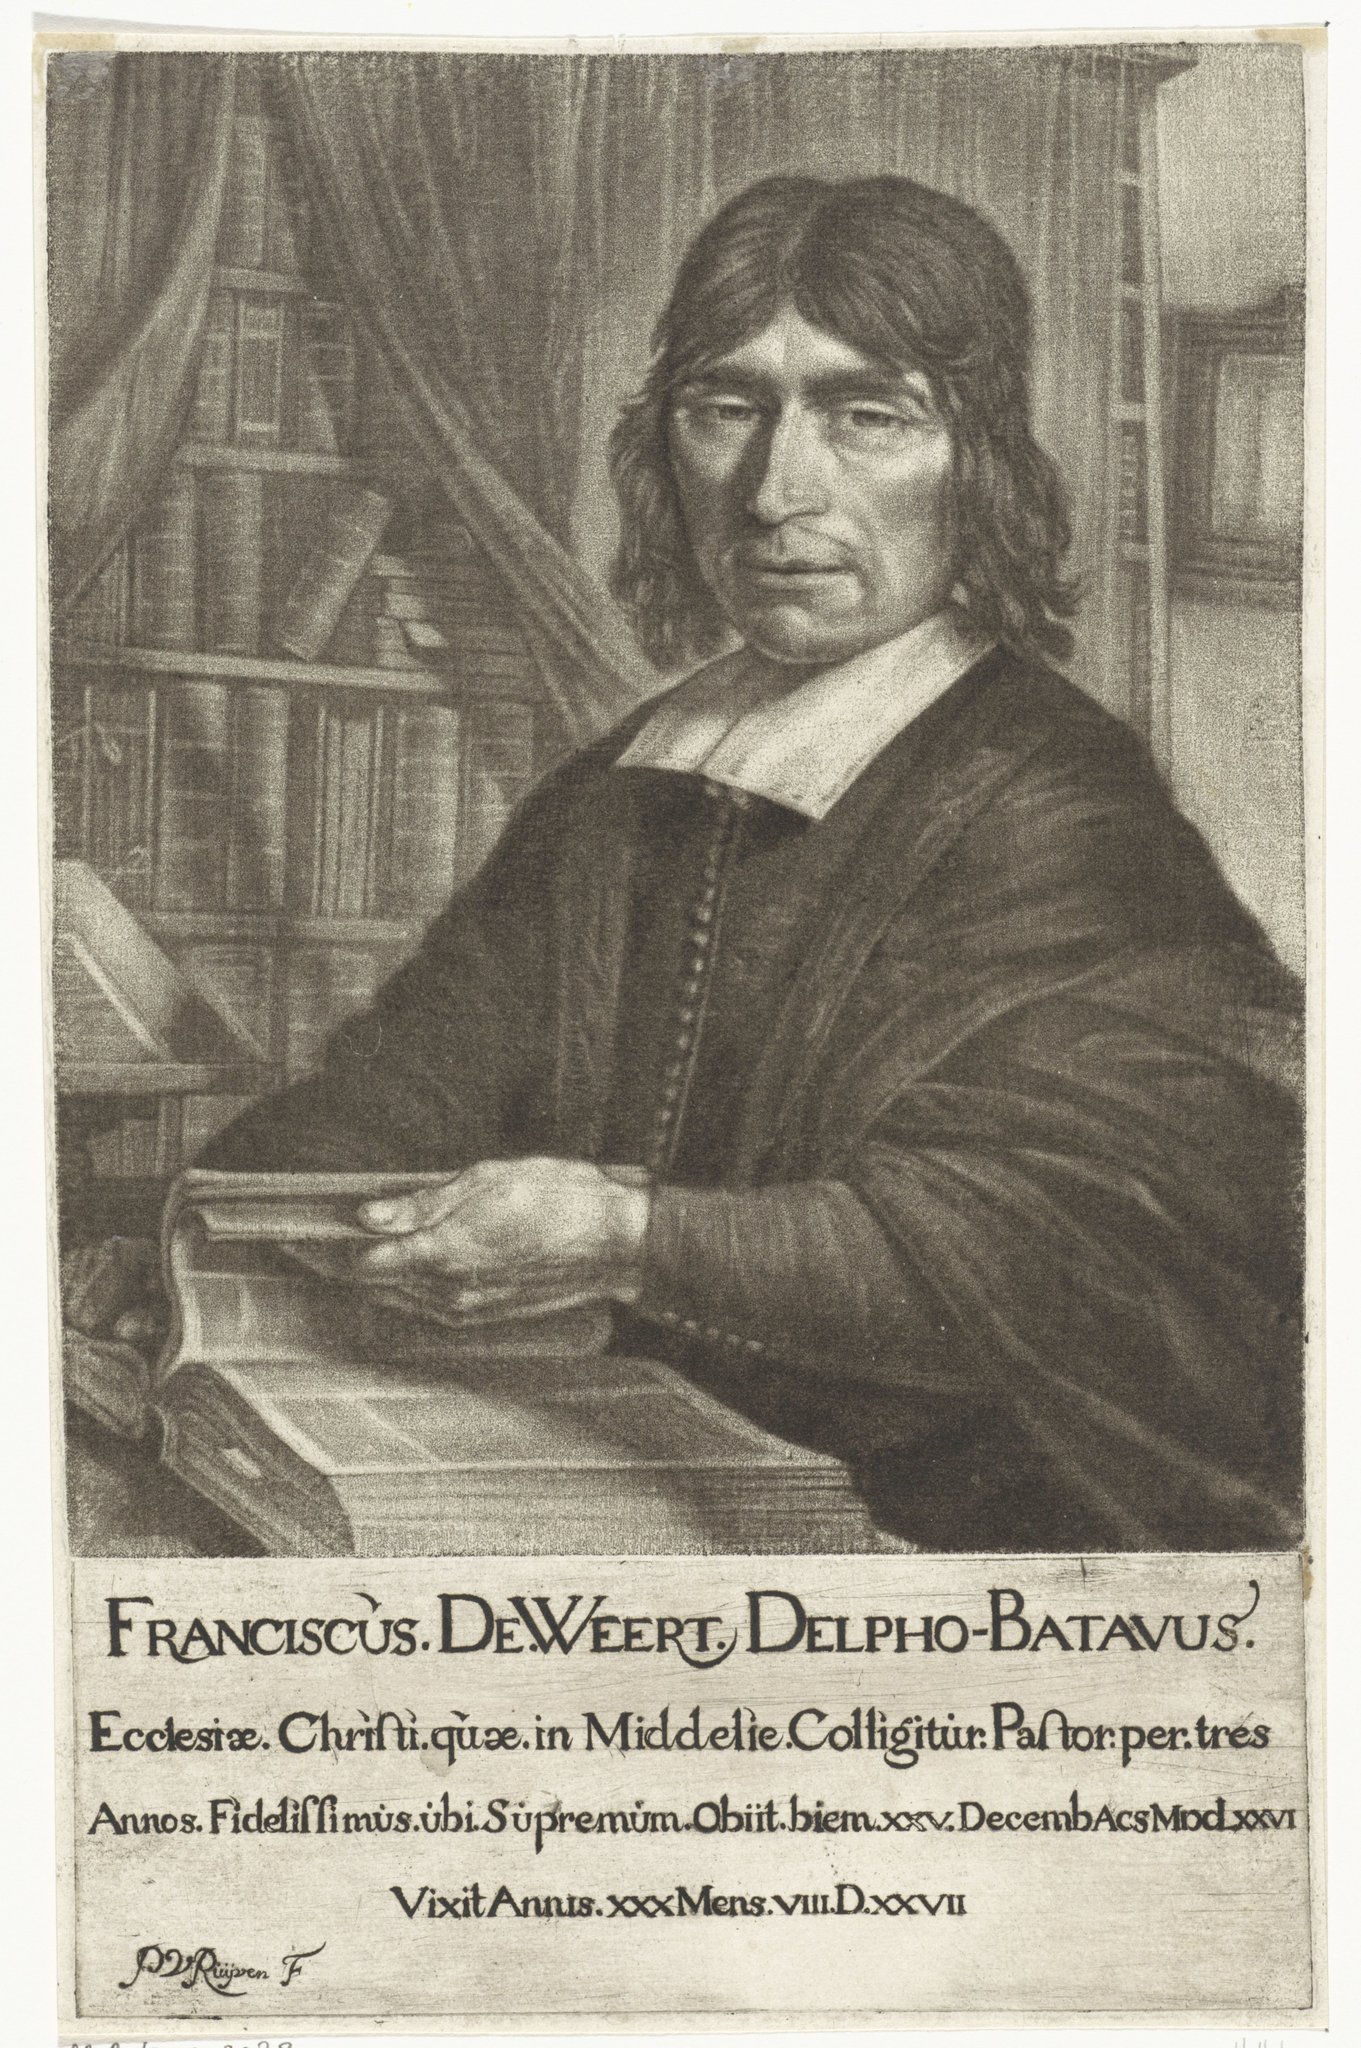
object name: print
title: Portret van de pastoor Franciscus de Weert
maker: pieter jansz. van ruyven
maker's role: painter, print maker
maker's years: 1651-1716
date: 1661-1719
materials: paper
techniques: engraving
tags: book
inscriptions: collector's mark: Lugt 2228